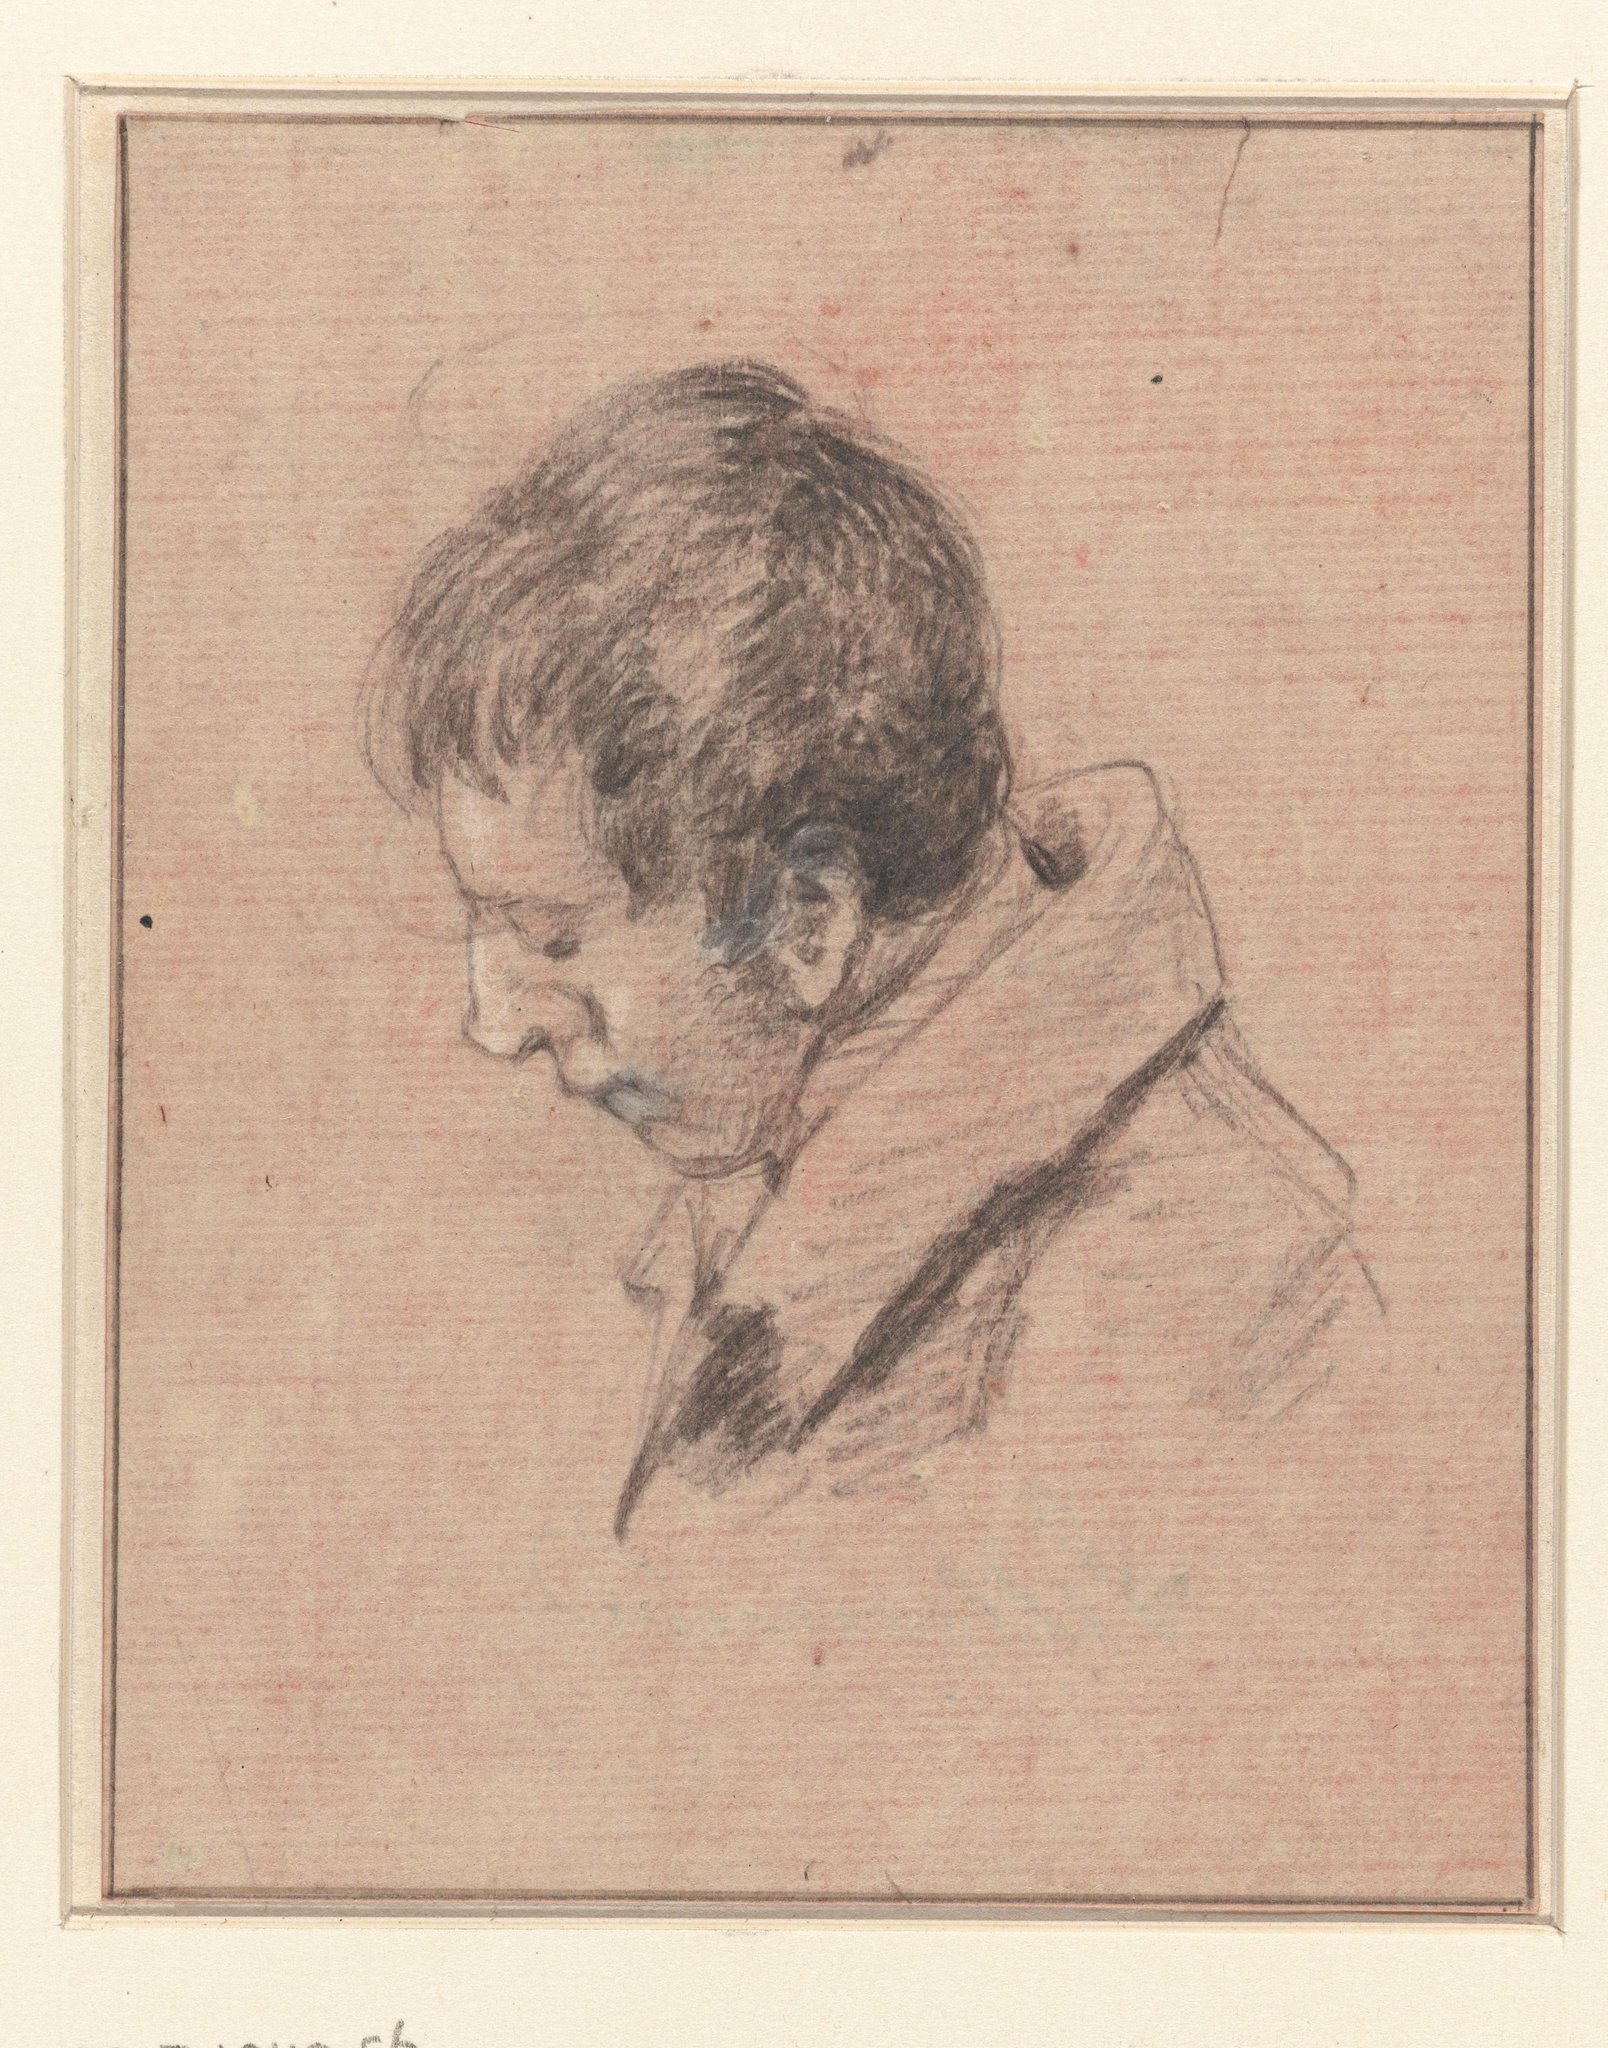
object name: drawing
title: Portret van Joannes Carolus Barnabas Sourdeval Duran de Ville Neuve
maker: Anonymous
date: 1800-1900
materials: chalk, paper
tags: historical persons, portrait, self-portrait of painter, portrait, self-portrait of artist, portrait, self-portrait of draughtsman